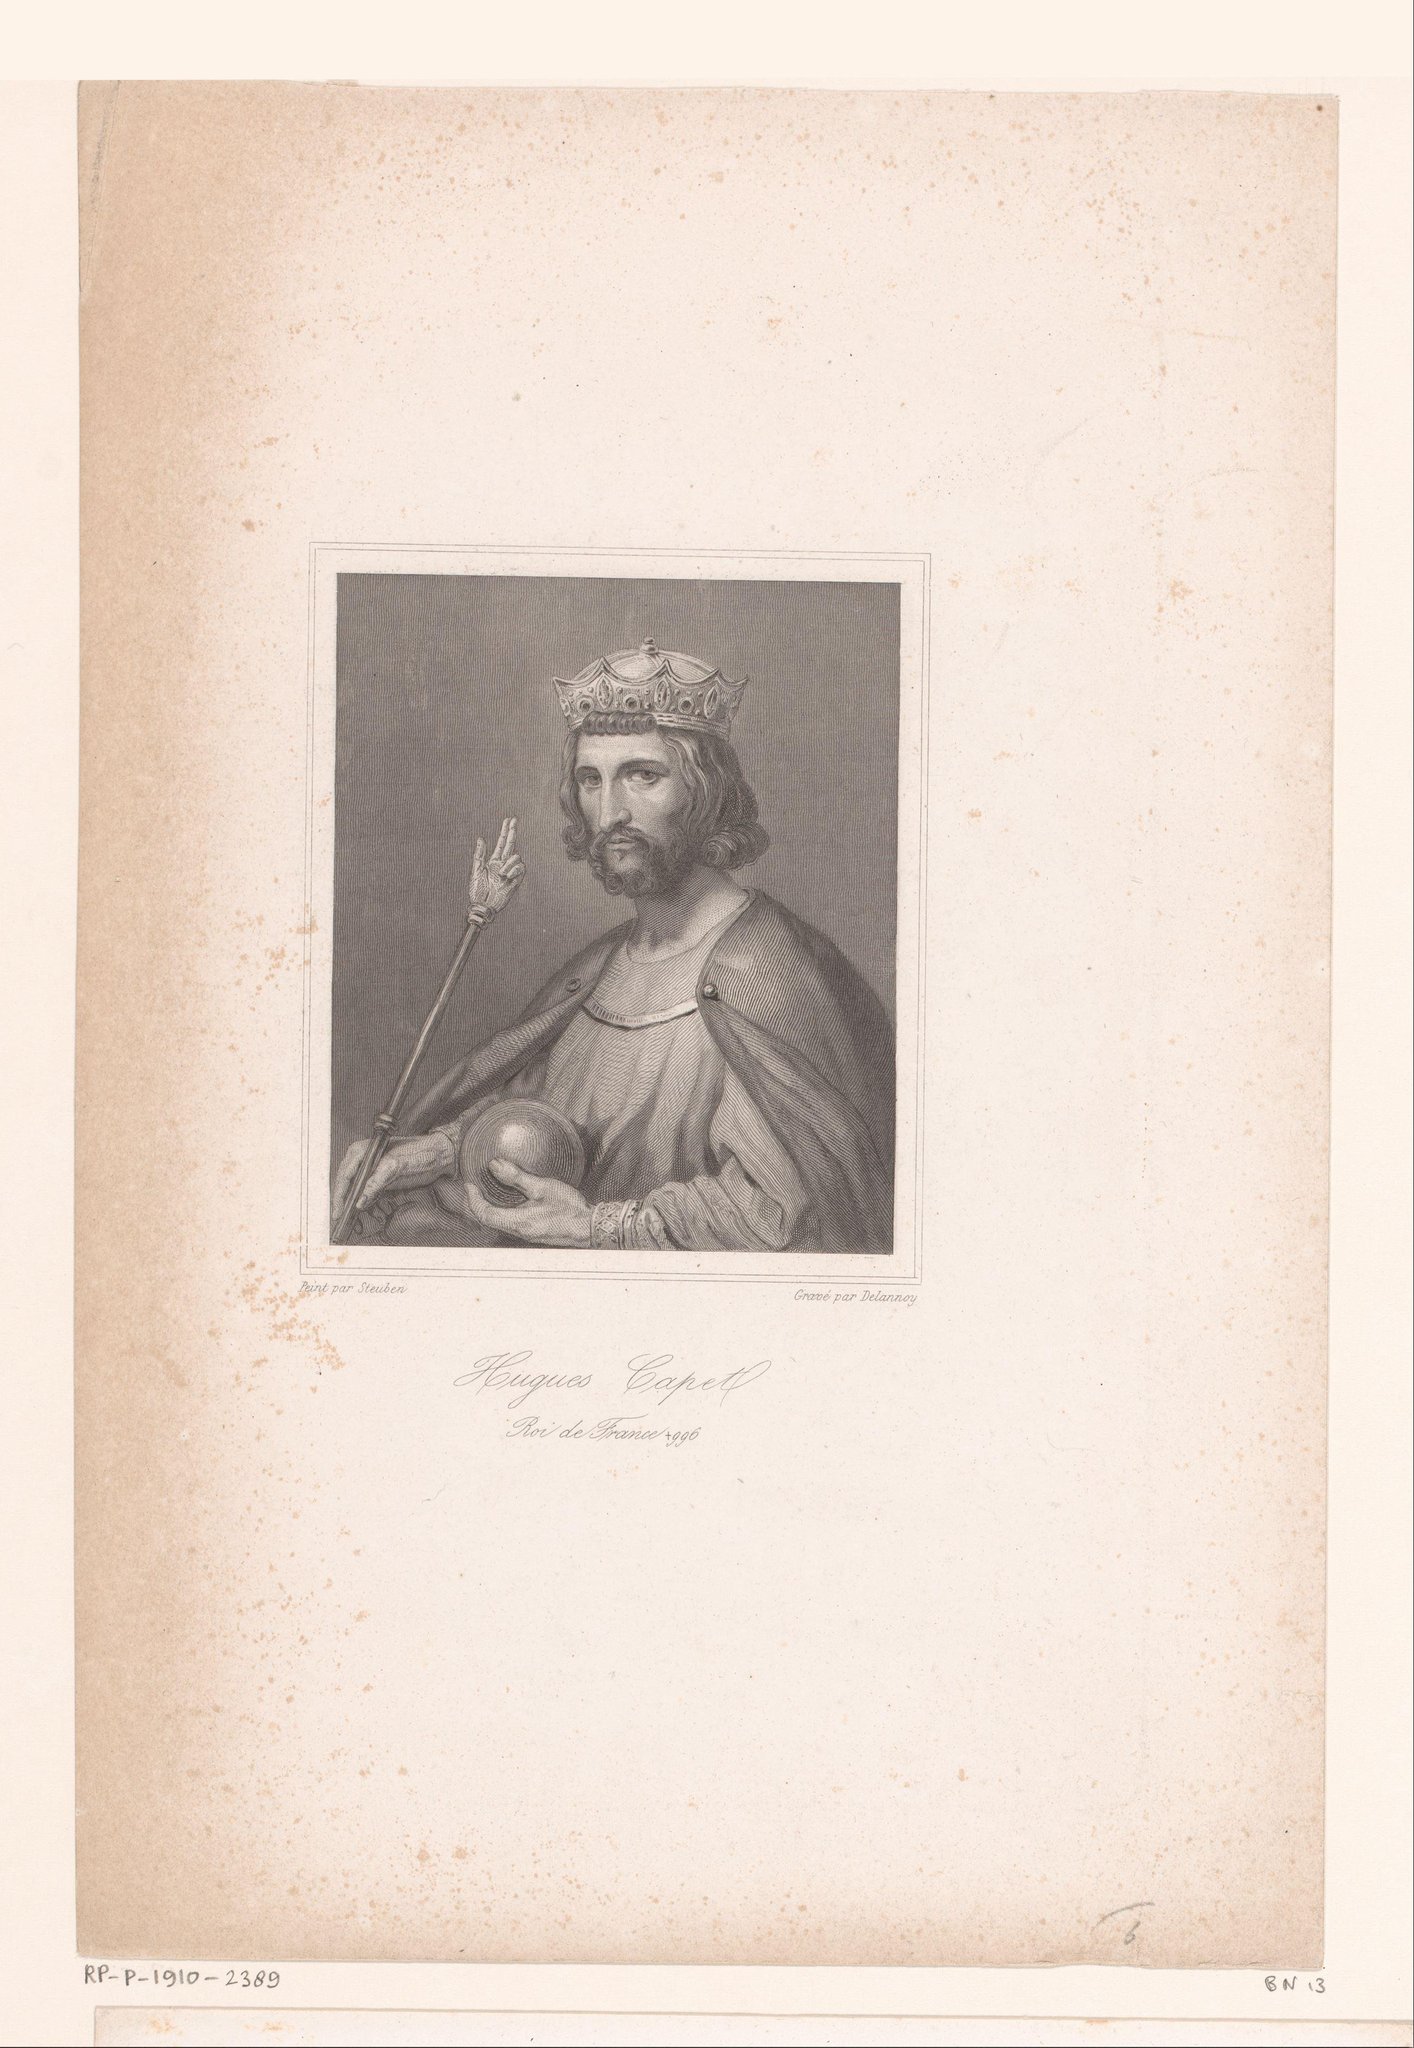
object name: book illustration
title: Portret van Hugo Capet, koning van Frankrijk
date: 1838-1841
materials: paper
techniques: engraving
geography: france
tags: historical persons, king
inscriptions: collector's mark: Lugt 2228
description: Prent uit: s.n. Galeries historiques de Versailles. Parijs: Charles Gavard, 1838-1841.